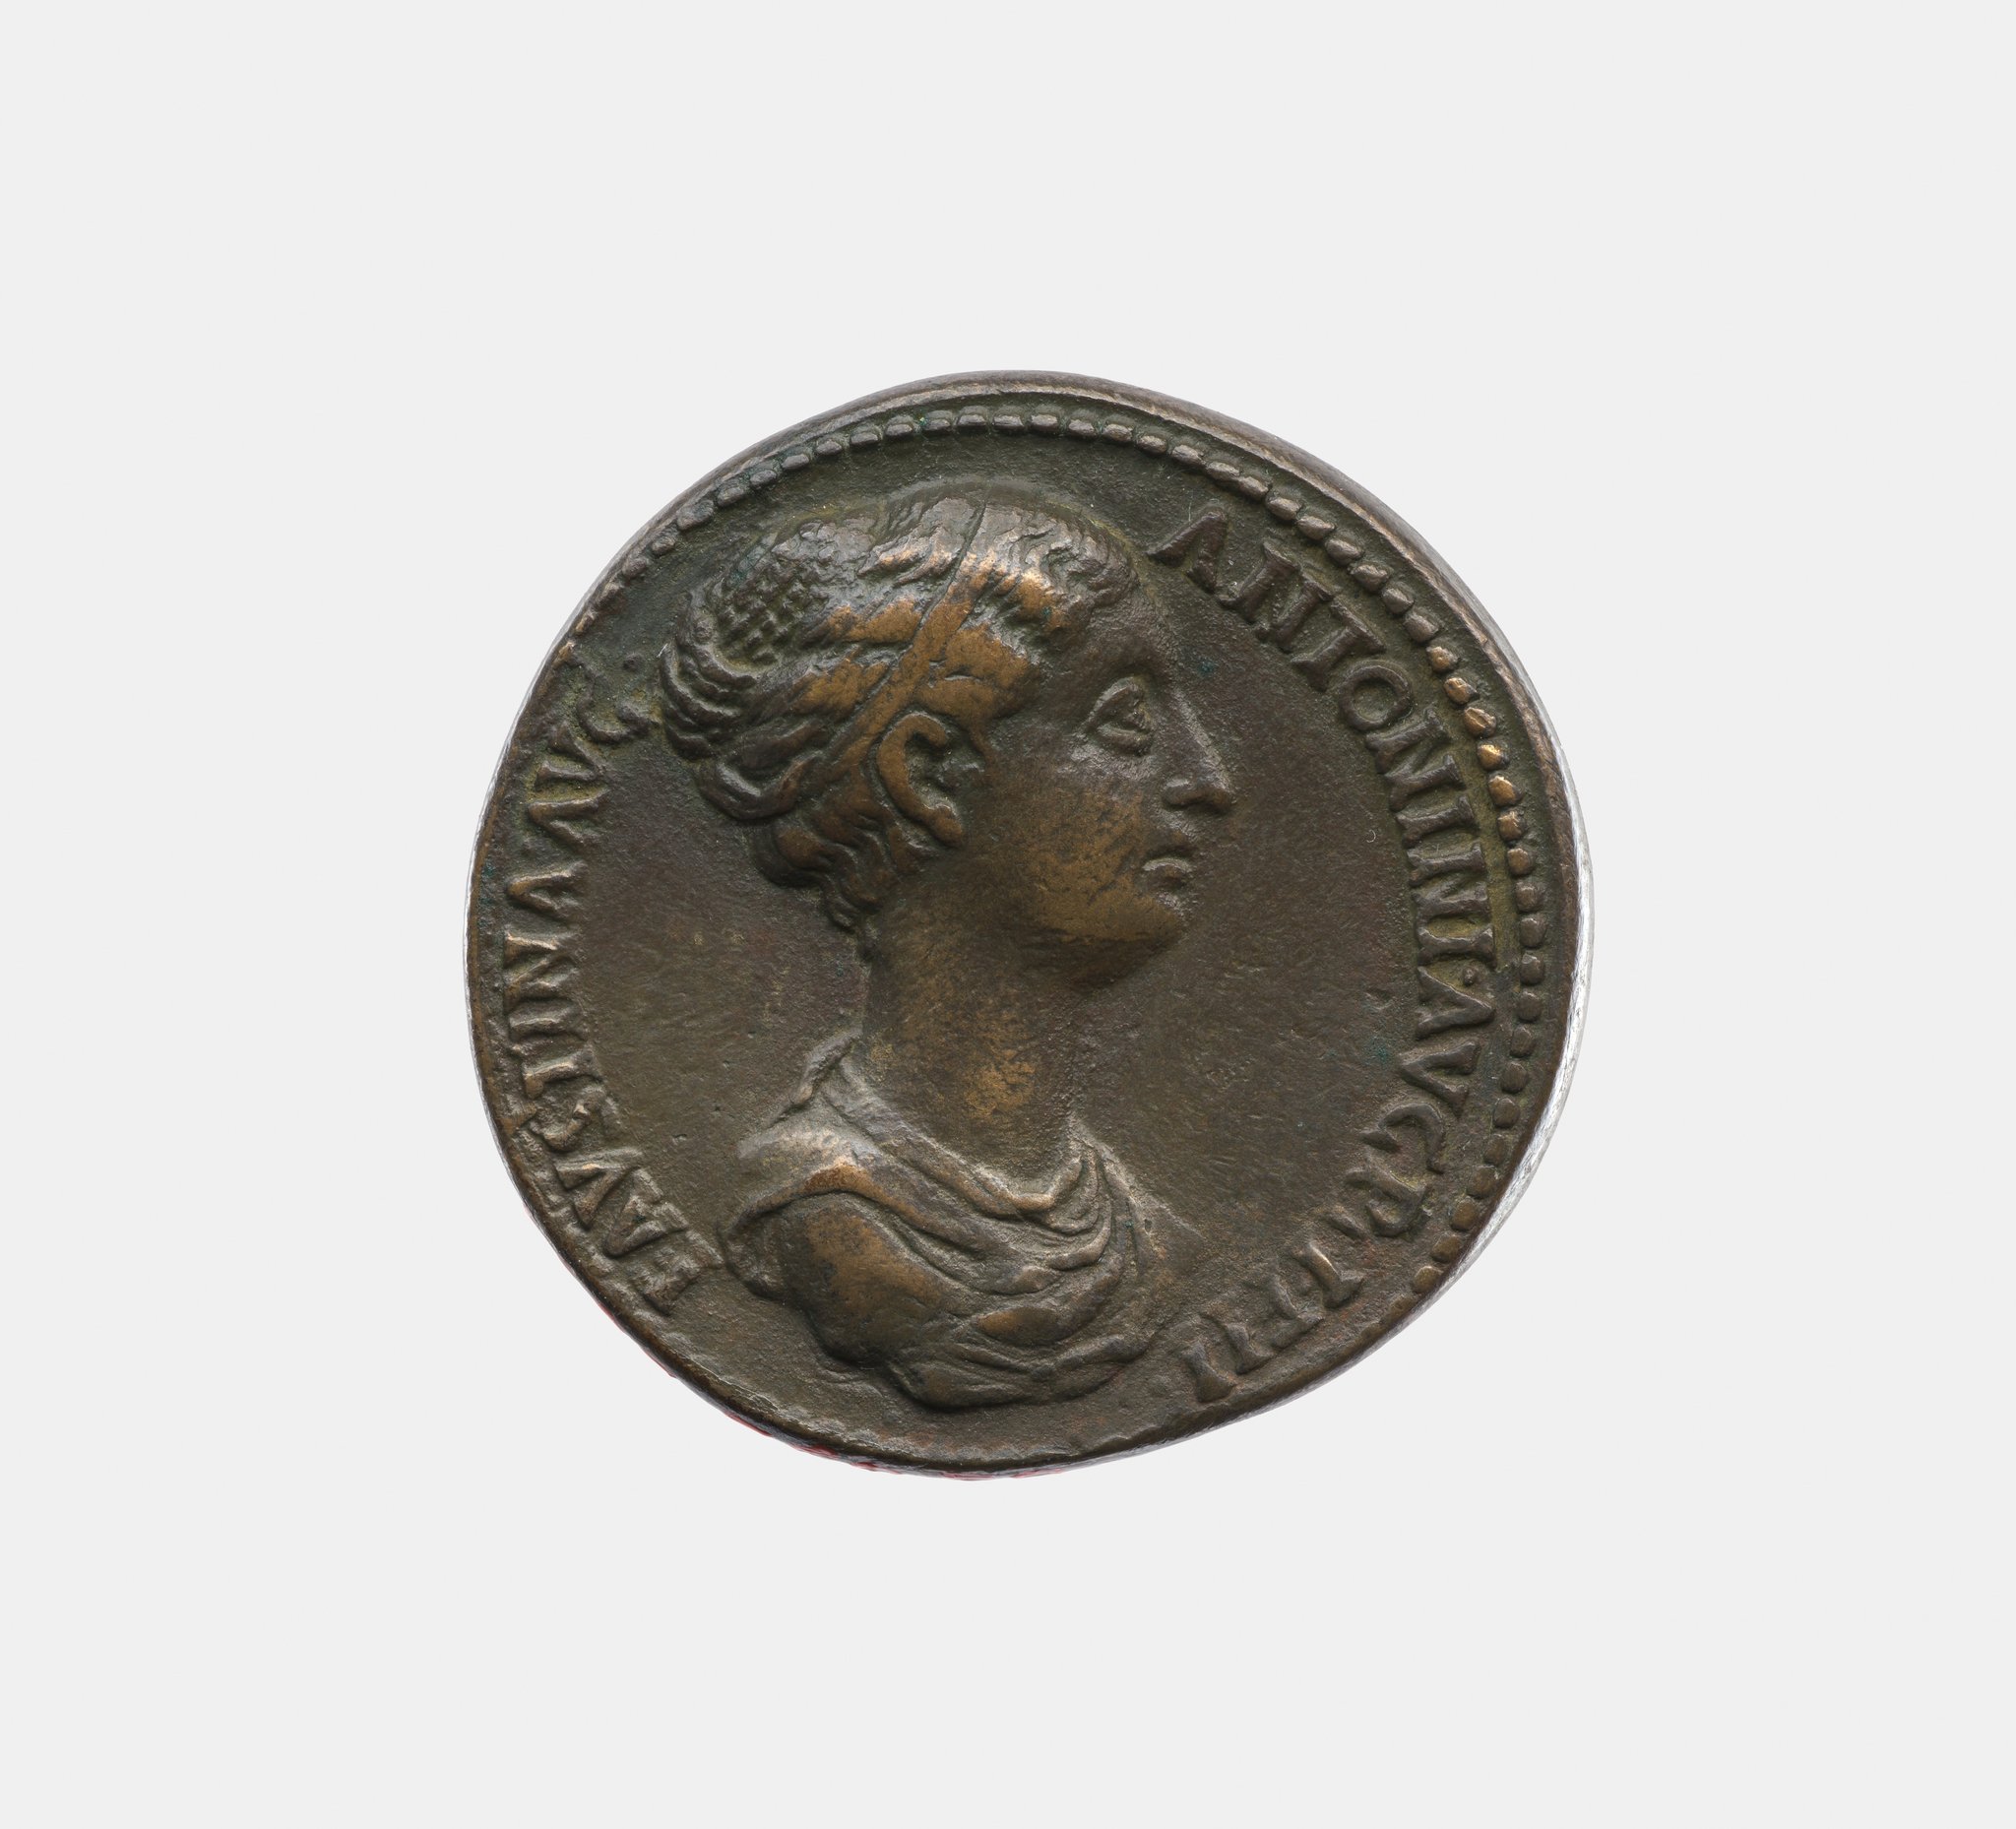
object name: medallion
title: Faustina Jr. d. A.D. 176, wife of Marcus Aurelius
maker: giovanni del cavino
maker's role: artist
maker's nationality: italian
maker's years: 1500-1570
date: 1500-1570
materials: bronze